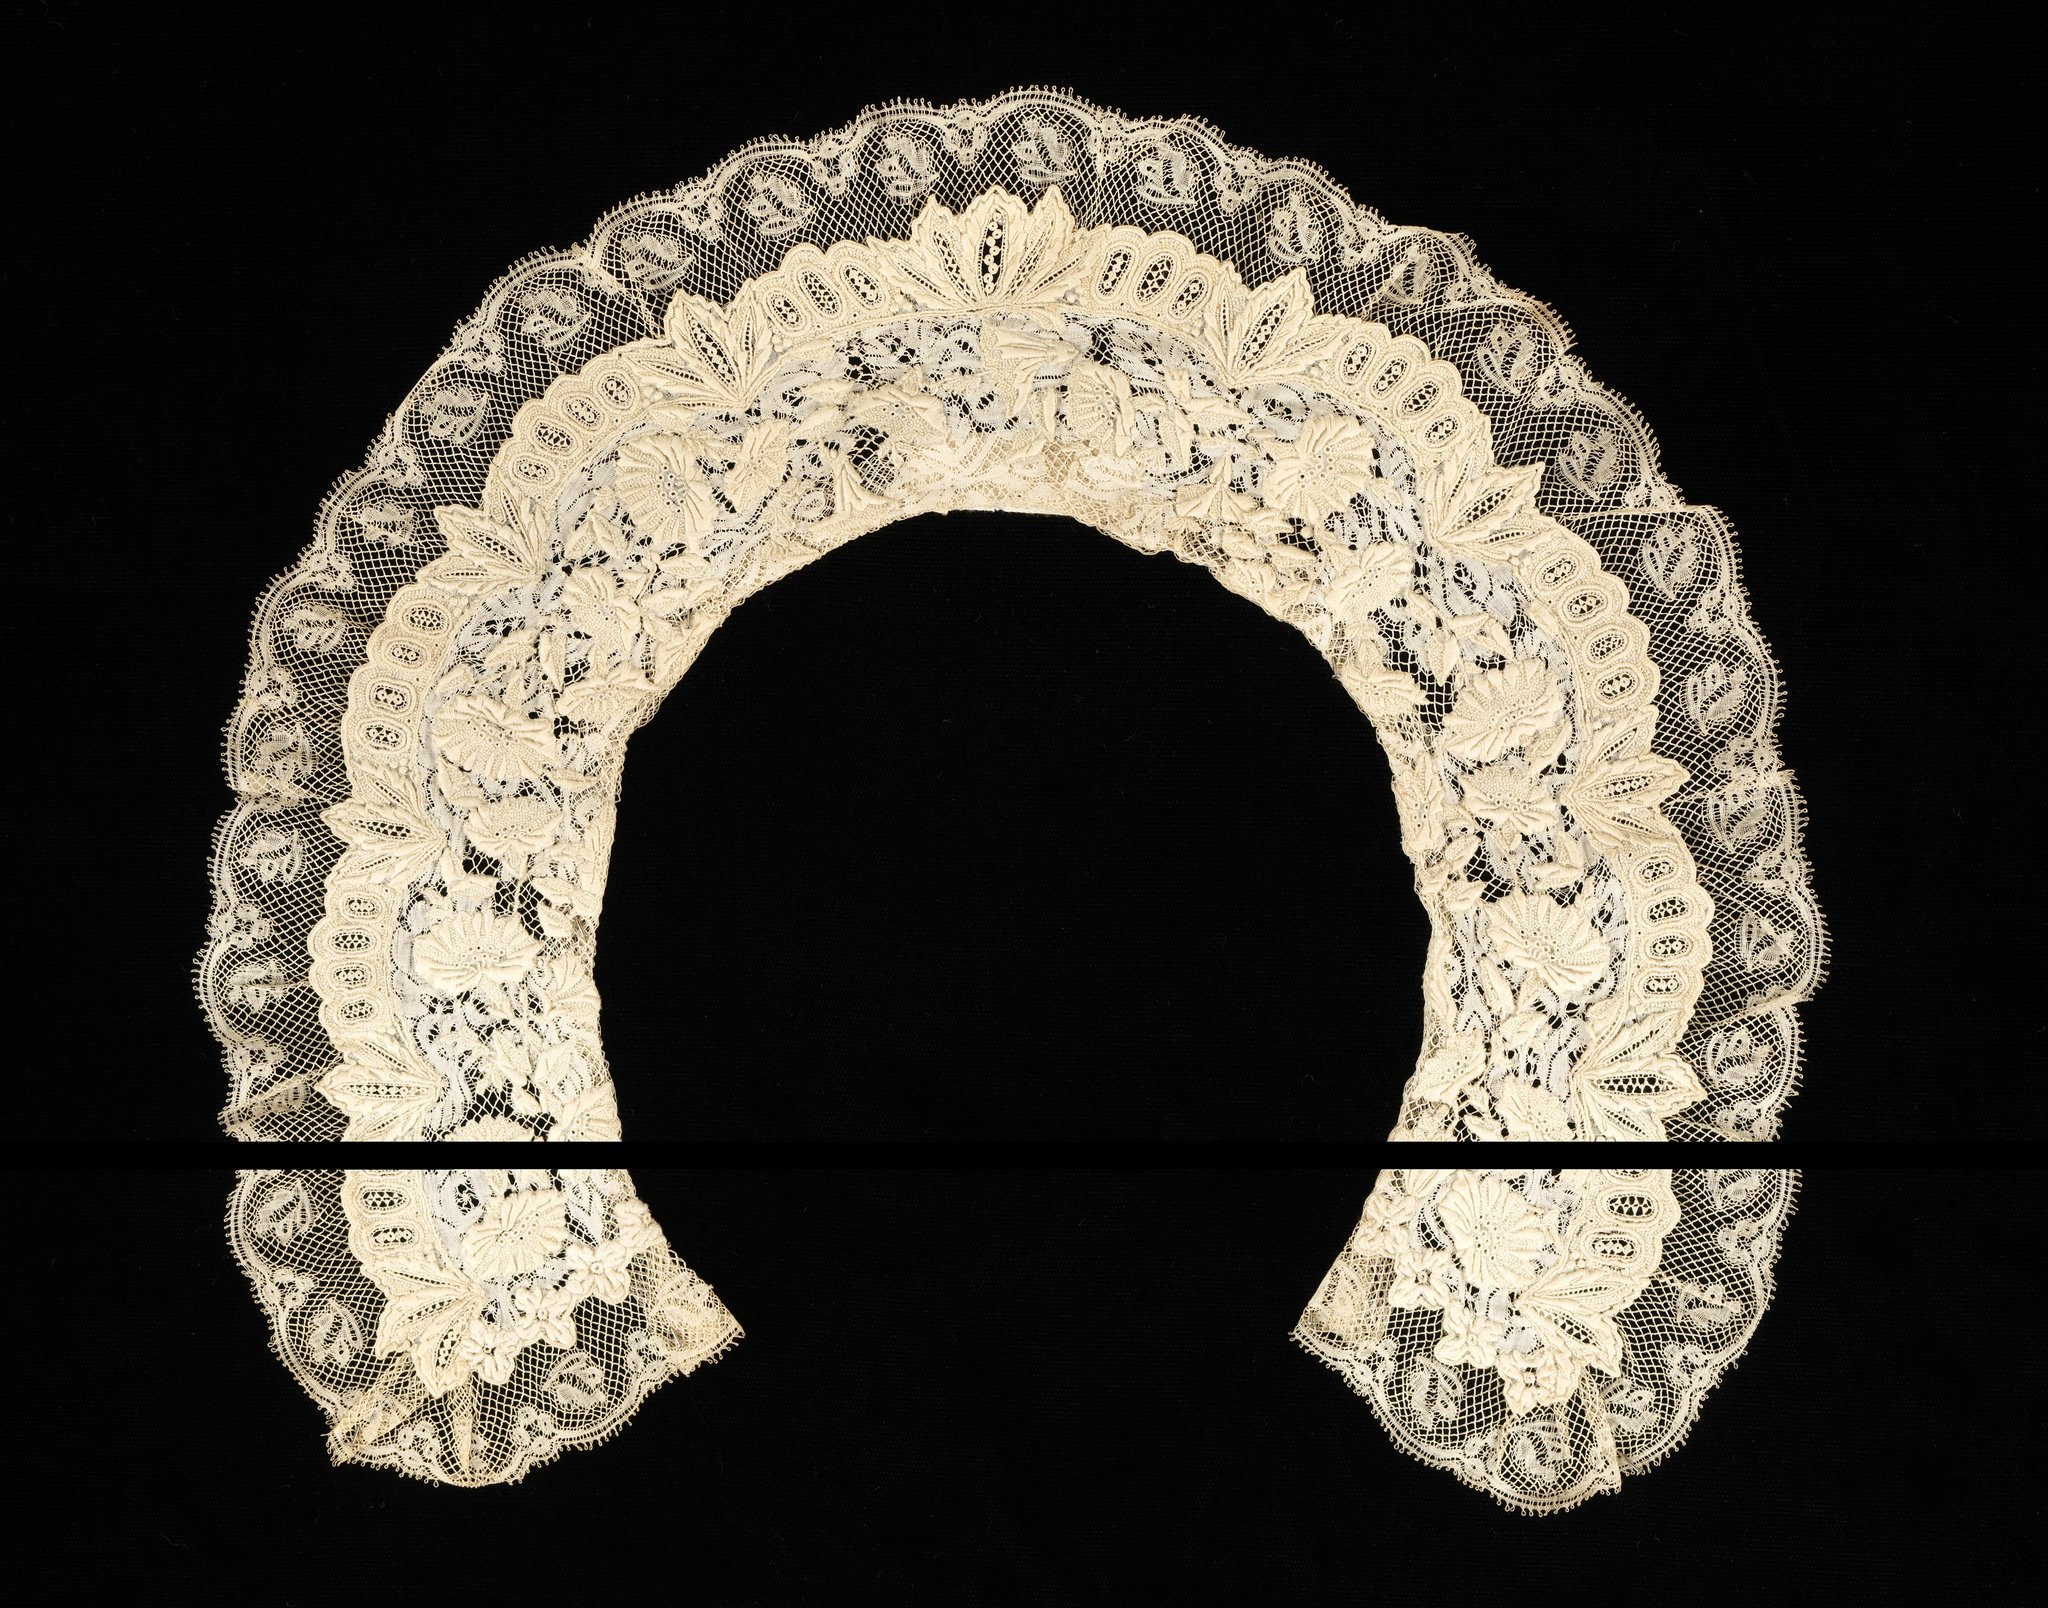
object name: collar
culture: american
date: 1860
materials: linen